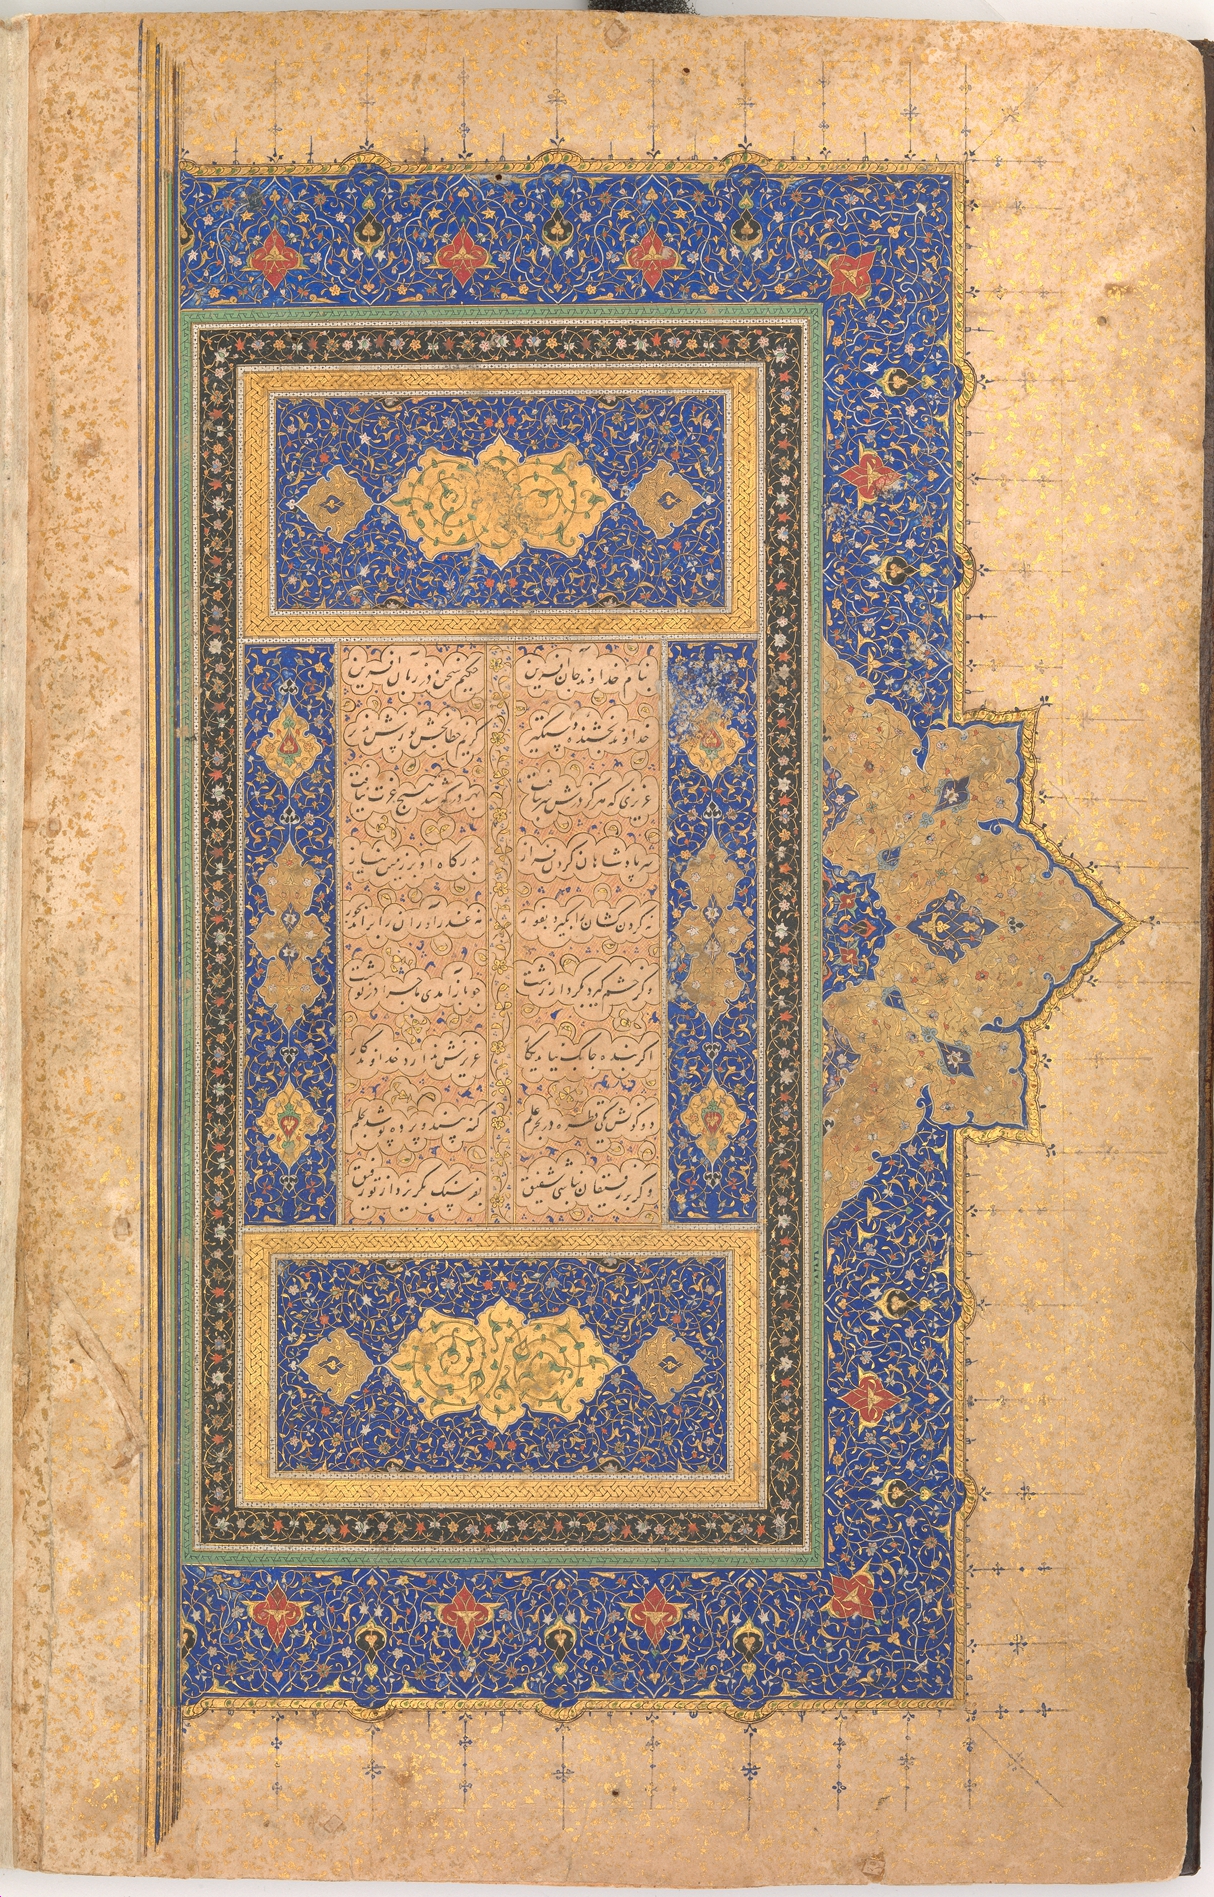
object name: illustrated manuscript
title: Illuminated Frontispiece of a Bustan of Sa`di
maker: sultan muhammad nur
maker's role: calligrapher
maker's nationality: iranian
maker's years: 1448-1561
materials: gold, ink, leather, paper, watercolor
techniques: bookbinding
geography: afghanistan